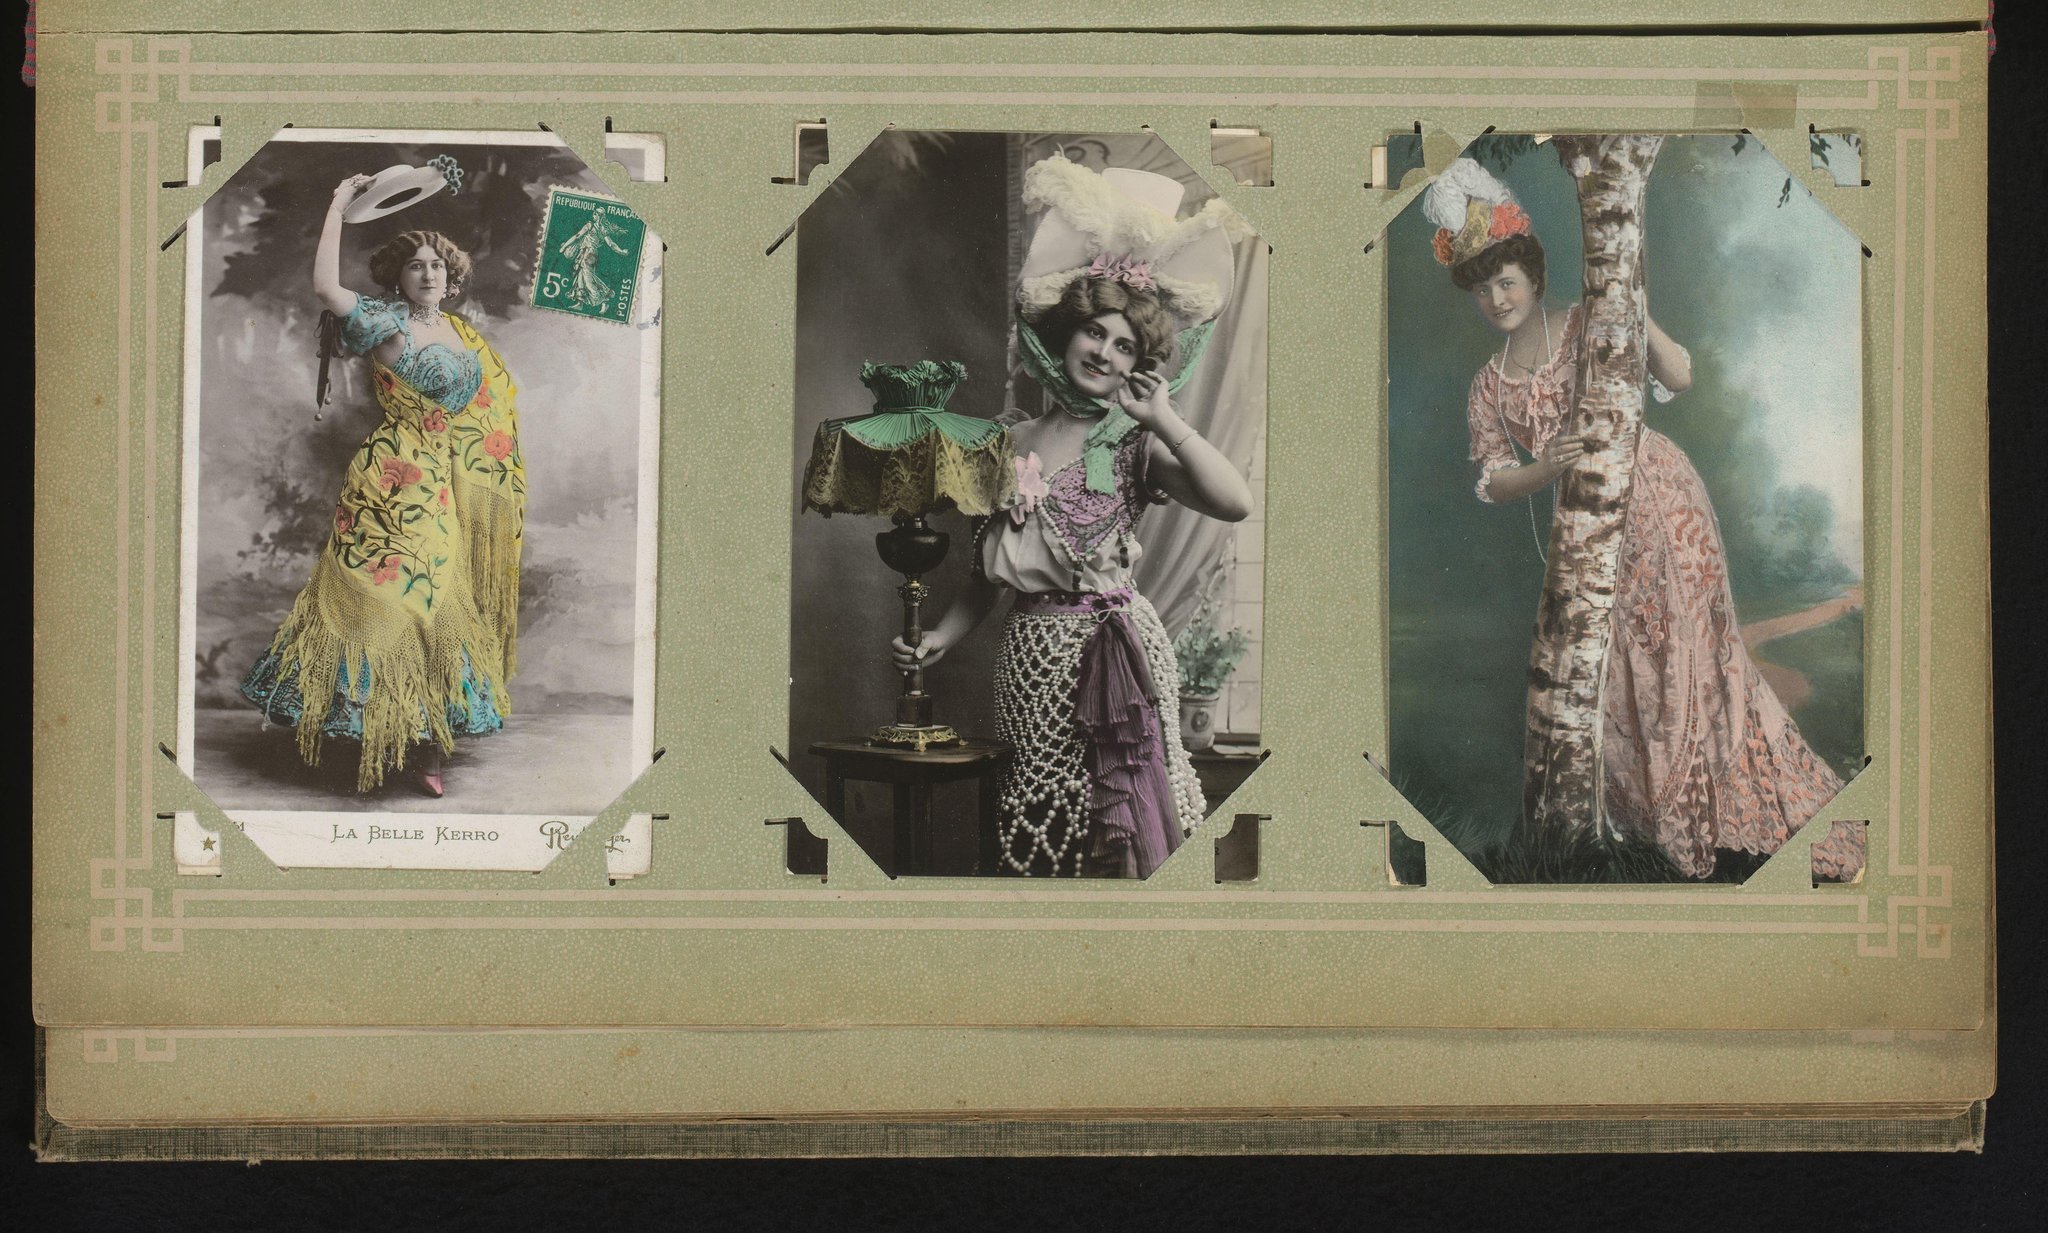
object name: album leaf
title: Drie portretten van jonge vrouwen, onder wie de actrice La Belle Kerro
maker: Anonymous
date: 1900-1930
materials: cardboard, photographic support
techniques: gelatin silver print, hand coloring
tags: historical persons - bb - woman, portrait of actor, actress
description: Deze foto's en prent maken deel uit van een album.